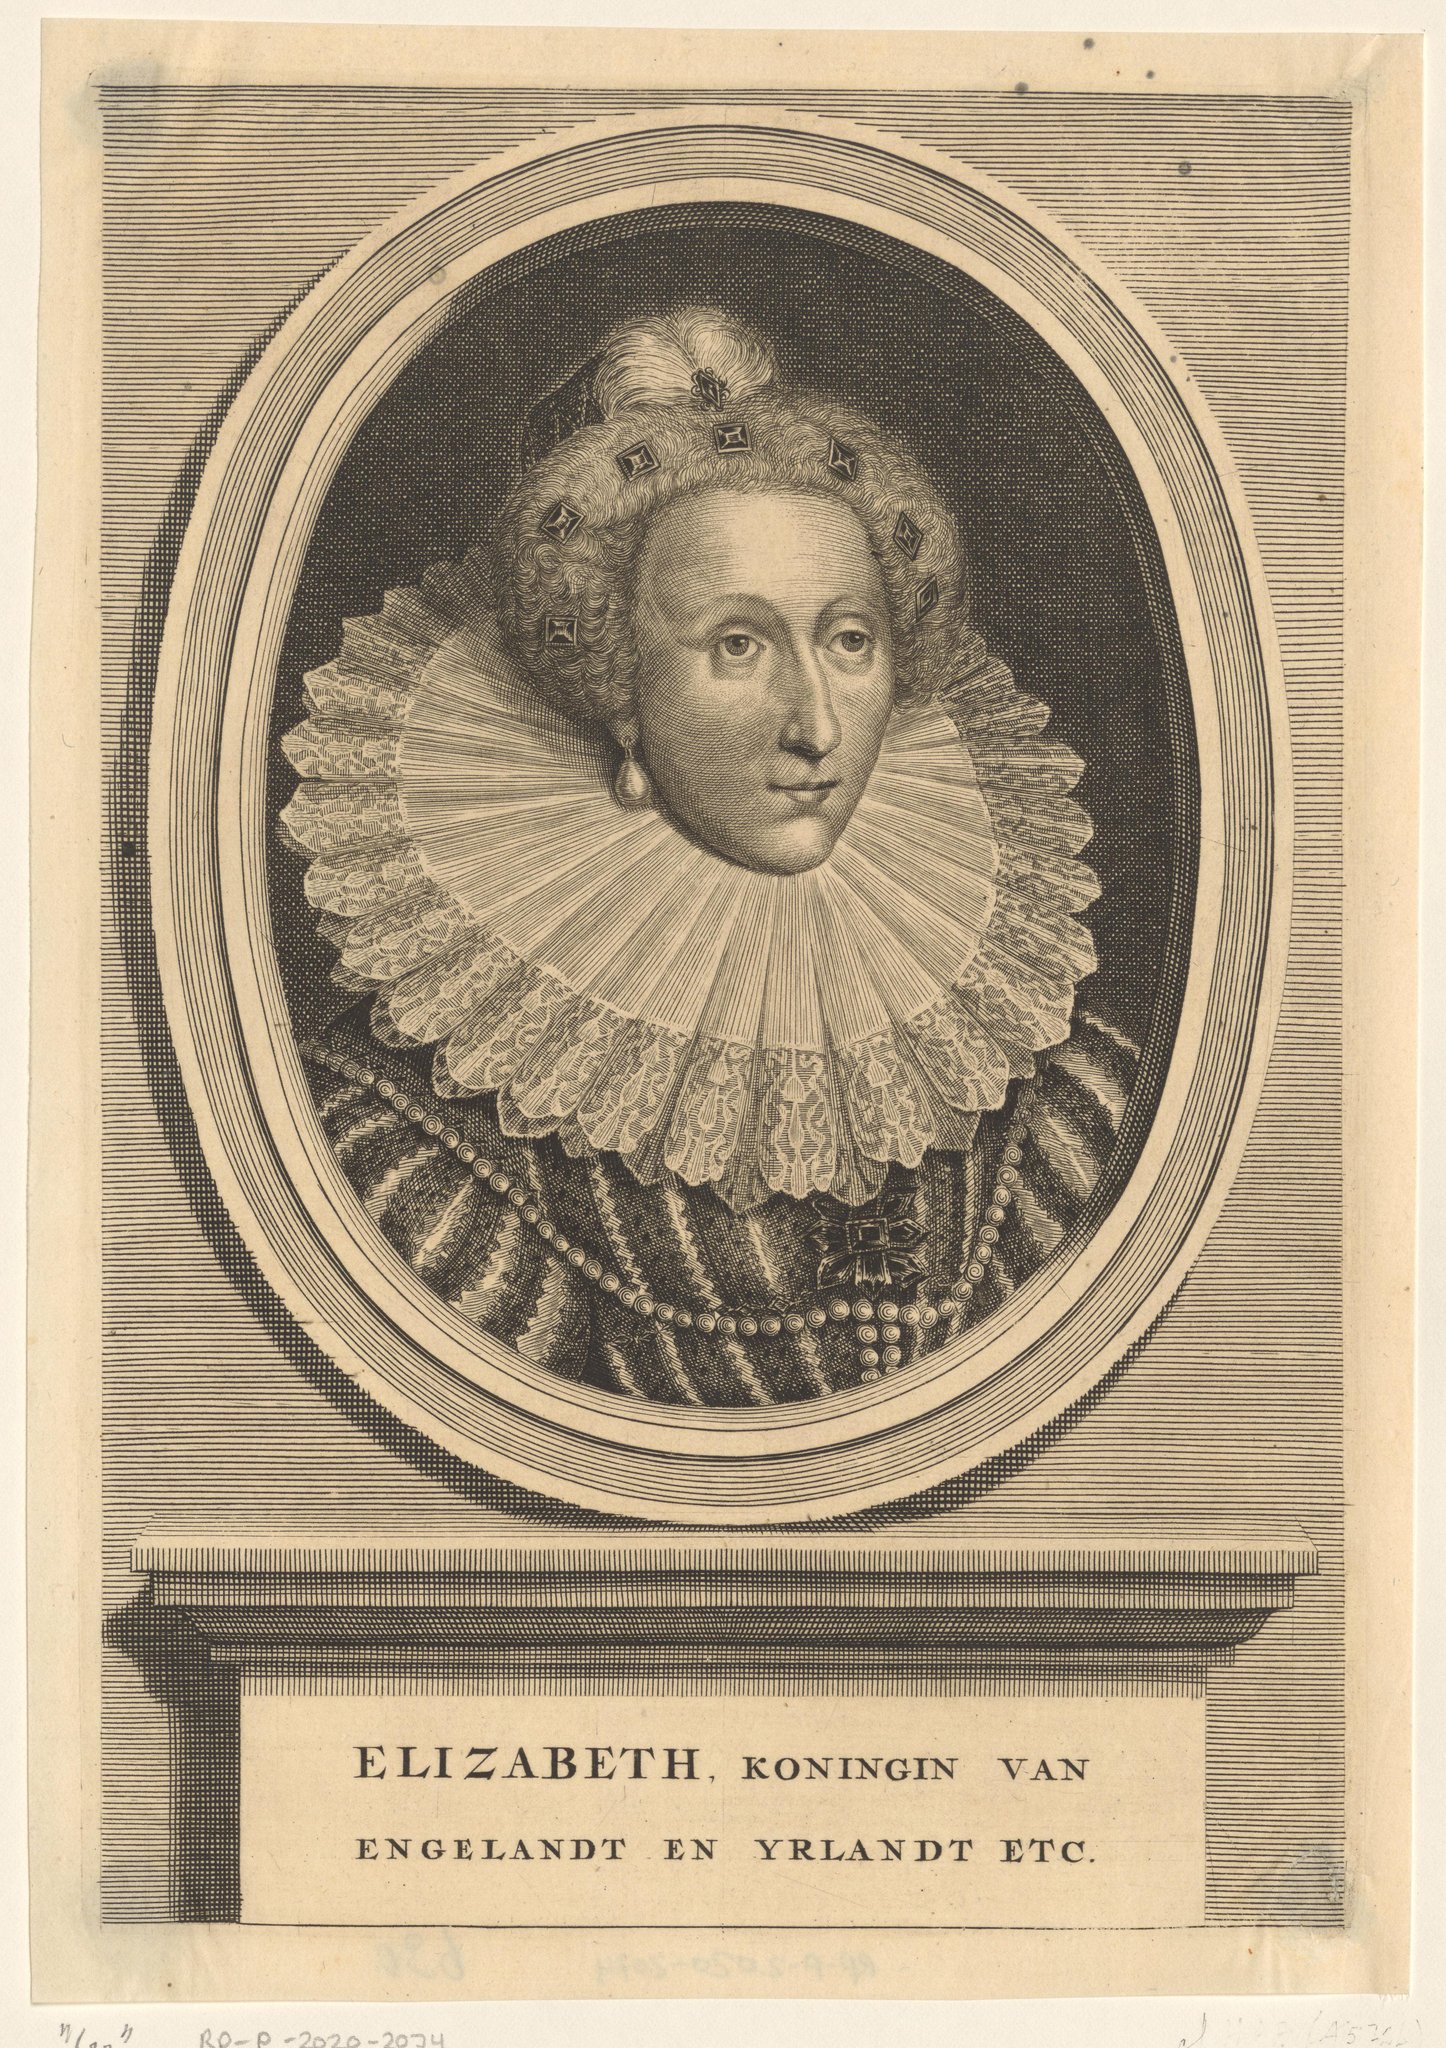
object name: print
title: Portret van Elizabeth I Tudor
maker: Anonymous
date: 1681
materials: paper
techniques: engraving, etching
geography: northern netherlands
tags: historical persons - bb - woman, queen, pearl; pearl necklace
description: Prent waarschijnlijk uit: Bor, Pieter Christiaensz. Oorsprongk, begin, en vervolgh der Nederlandsche oorlogen, beroerten (...). Amsterdam: weduwe Joannes Someren et al., 1681, dl. 3. Tweede staat van prent gebruikt in: Clerc, Jean Le. Geschiedenissen der Vereenigde Nederlanden (...). Amsterdam: Zacharias Chatelain, 1730, dl. 1.